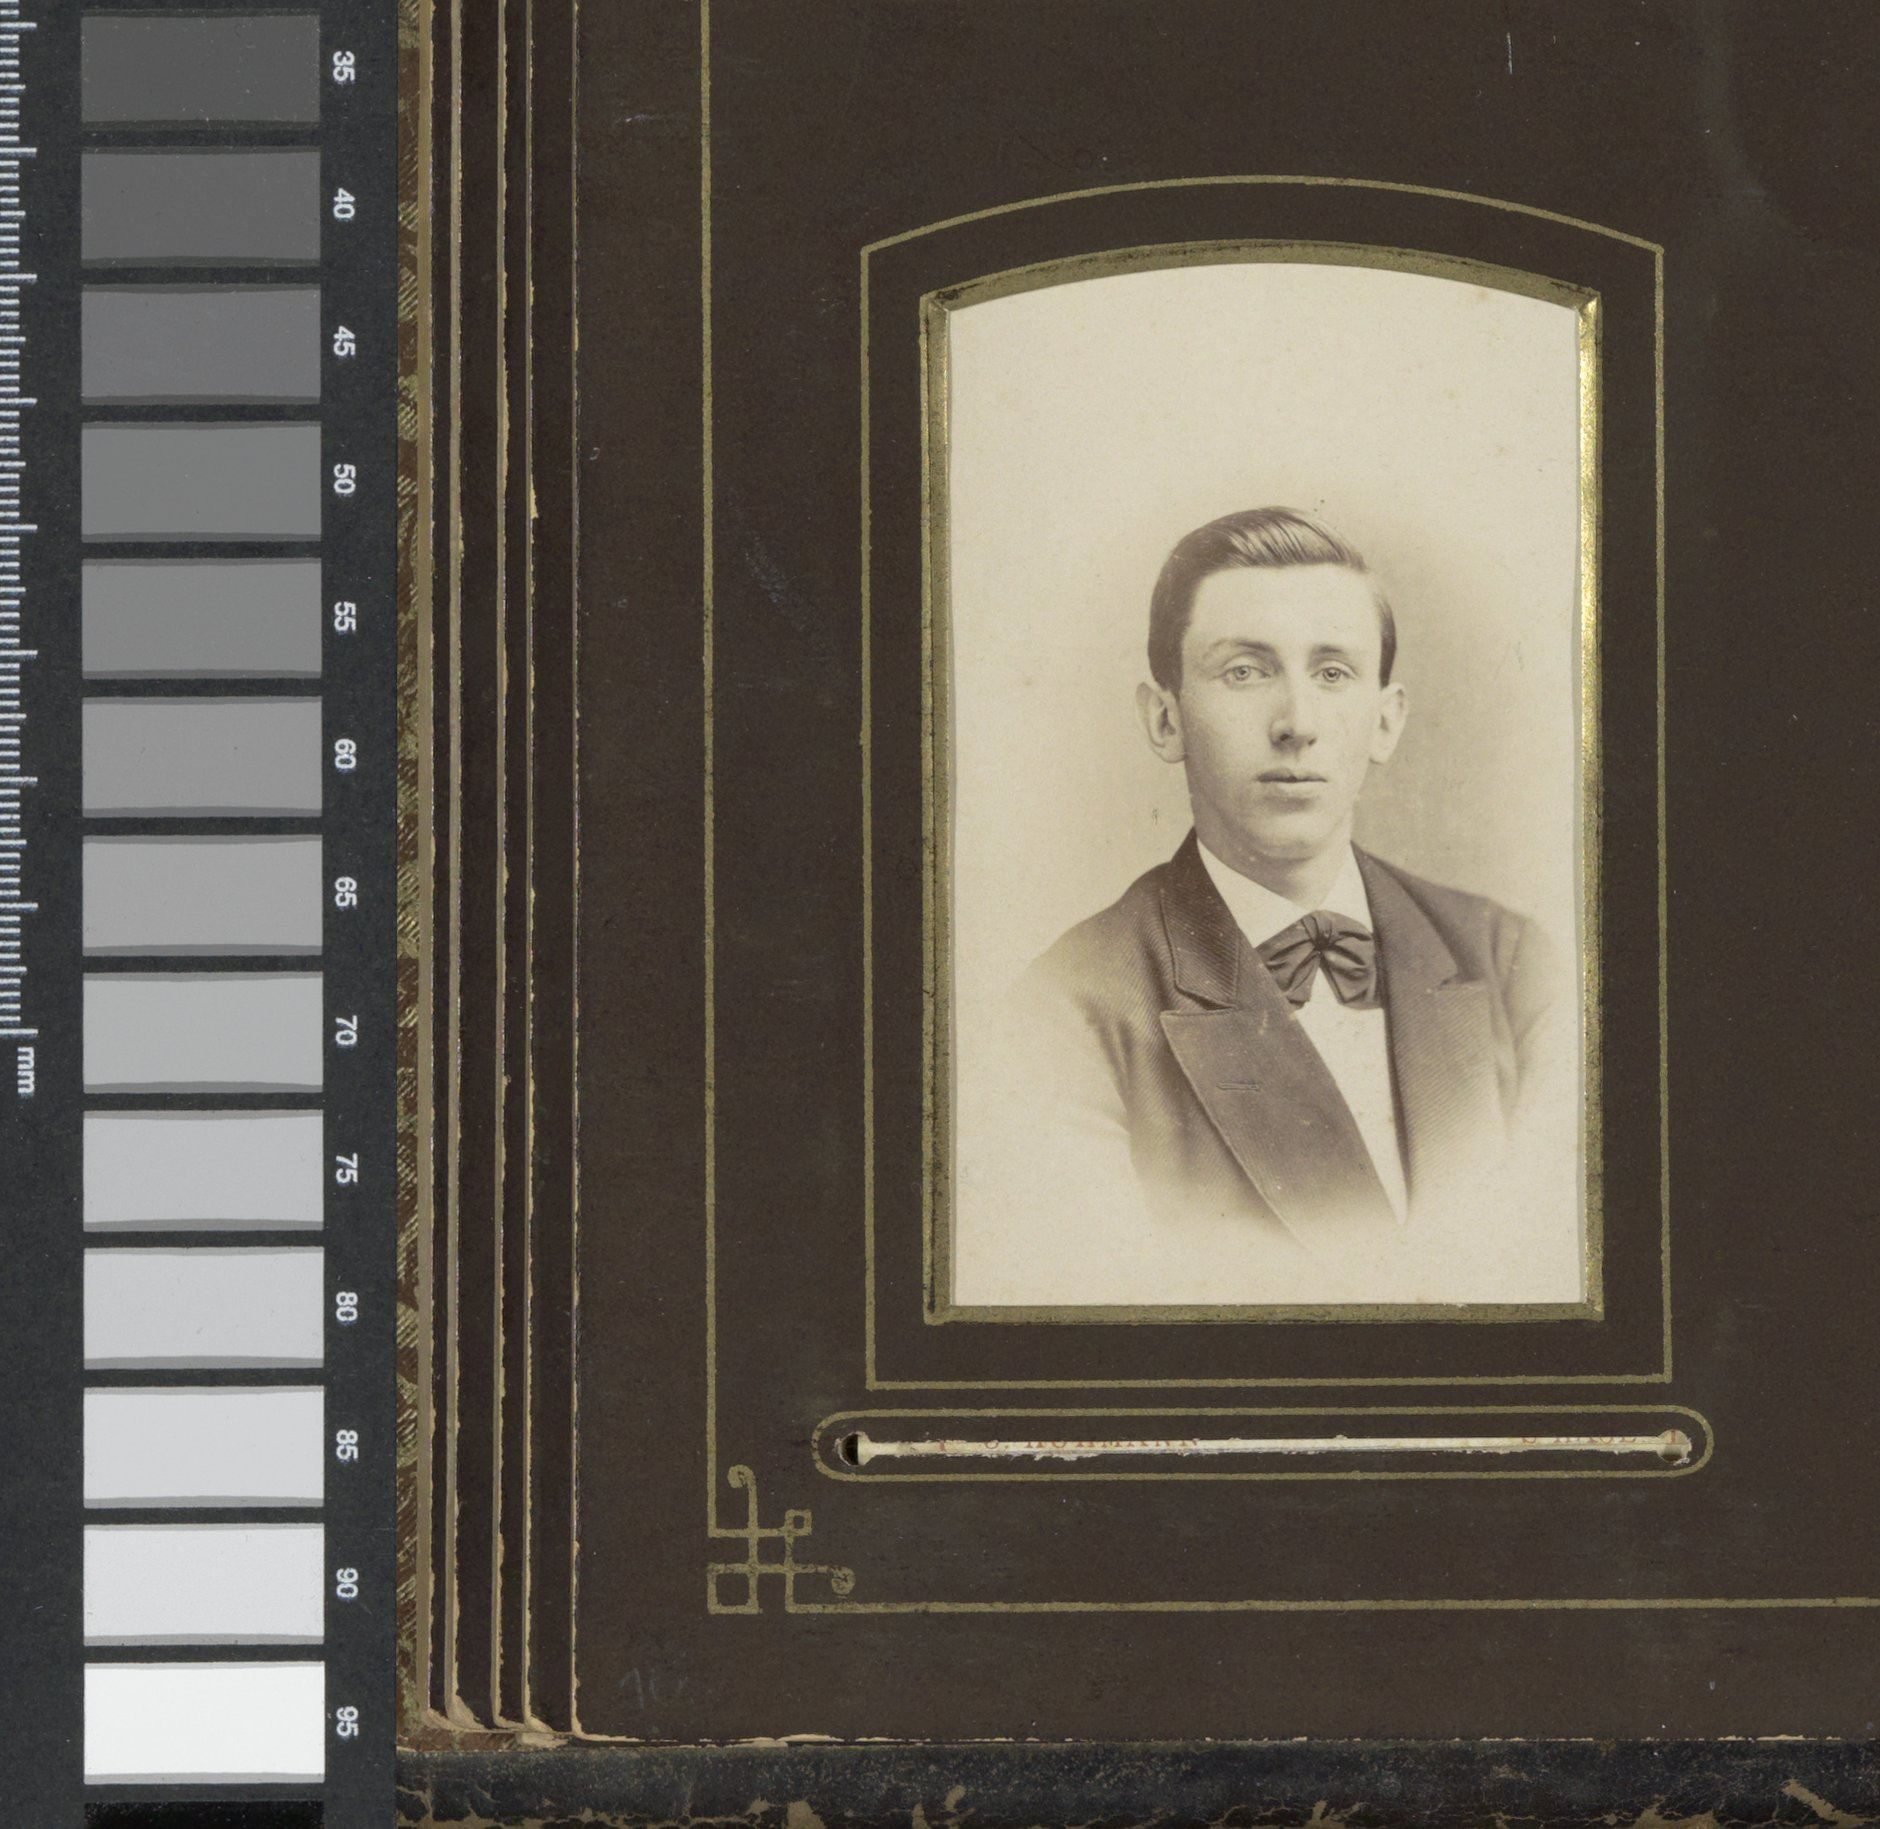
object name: photograph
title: Portret van een jongeman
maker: jacob hohmann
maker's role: fotograaf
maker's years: 1833-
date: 1863-1892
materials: cardboard, paper, photographic support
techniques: albumen print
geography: the hague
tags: historical persons, youth, adolescent, the hague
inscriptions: address: ‘Willemstraat 59, 's Gravenhage’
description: Onderdeel van Fotoalbum van de families Matthes, Doorman en Van Thiel.